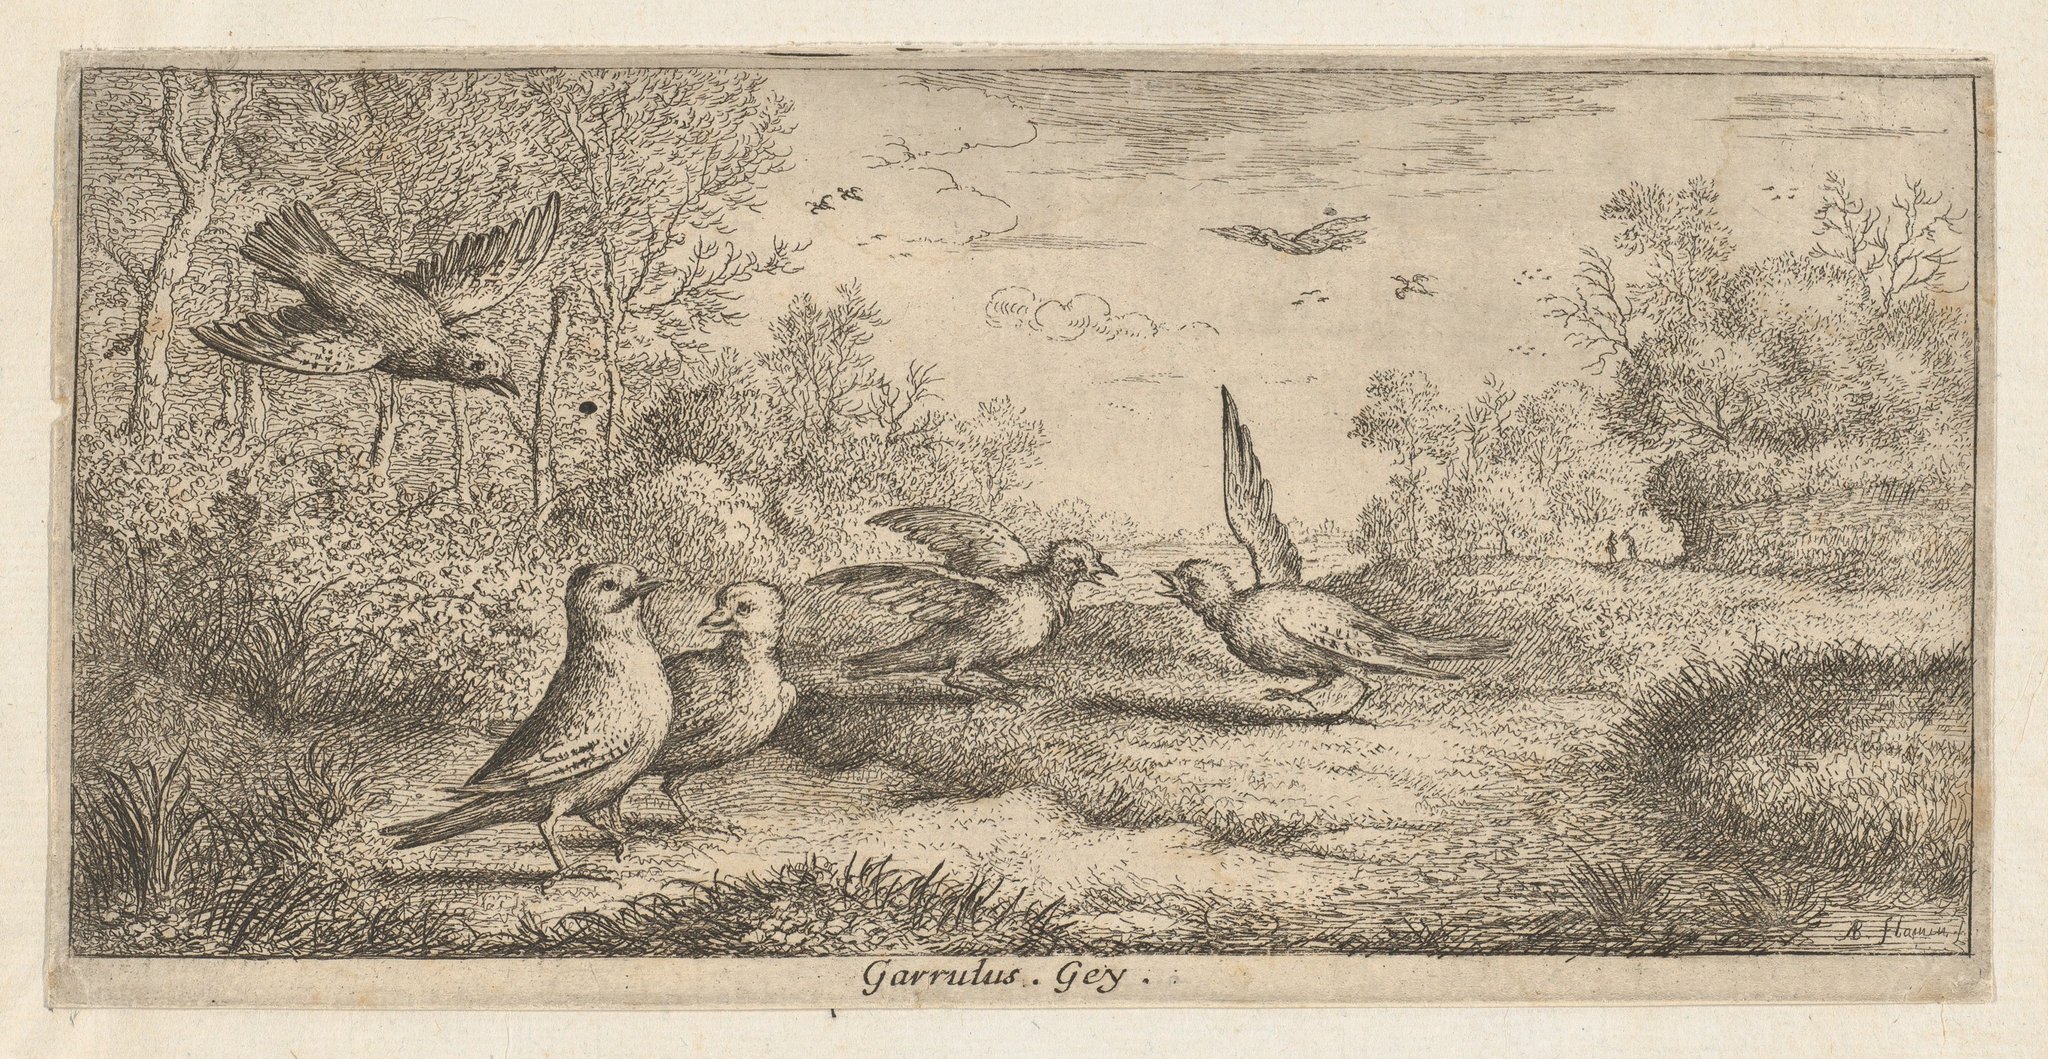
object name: print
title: Garrulus, Gey (The Jay), from "Livre d'Oyseaux" (Book of Birds)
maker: albert flamen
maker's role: artist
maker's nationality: flemish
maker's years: 1615-1688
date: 1655-1660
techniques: etching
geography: france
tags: birds